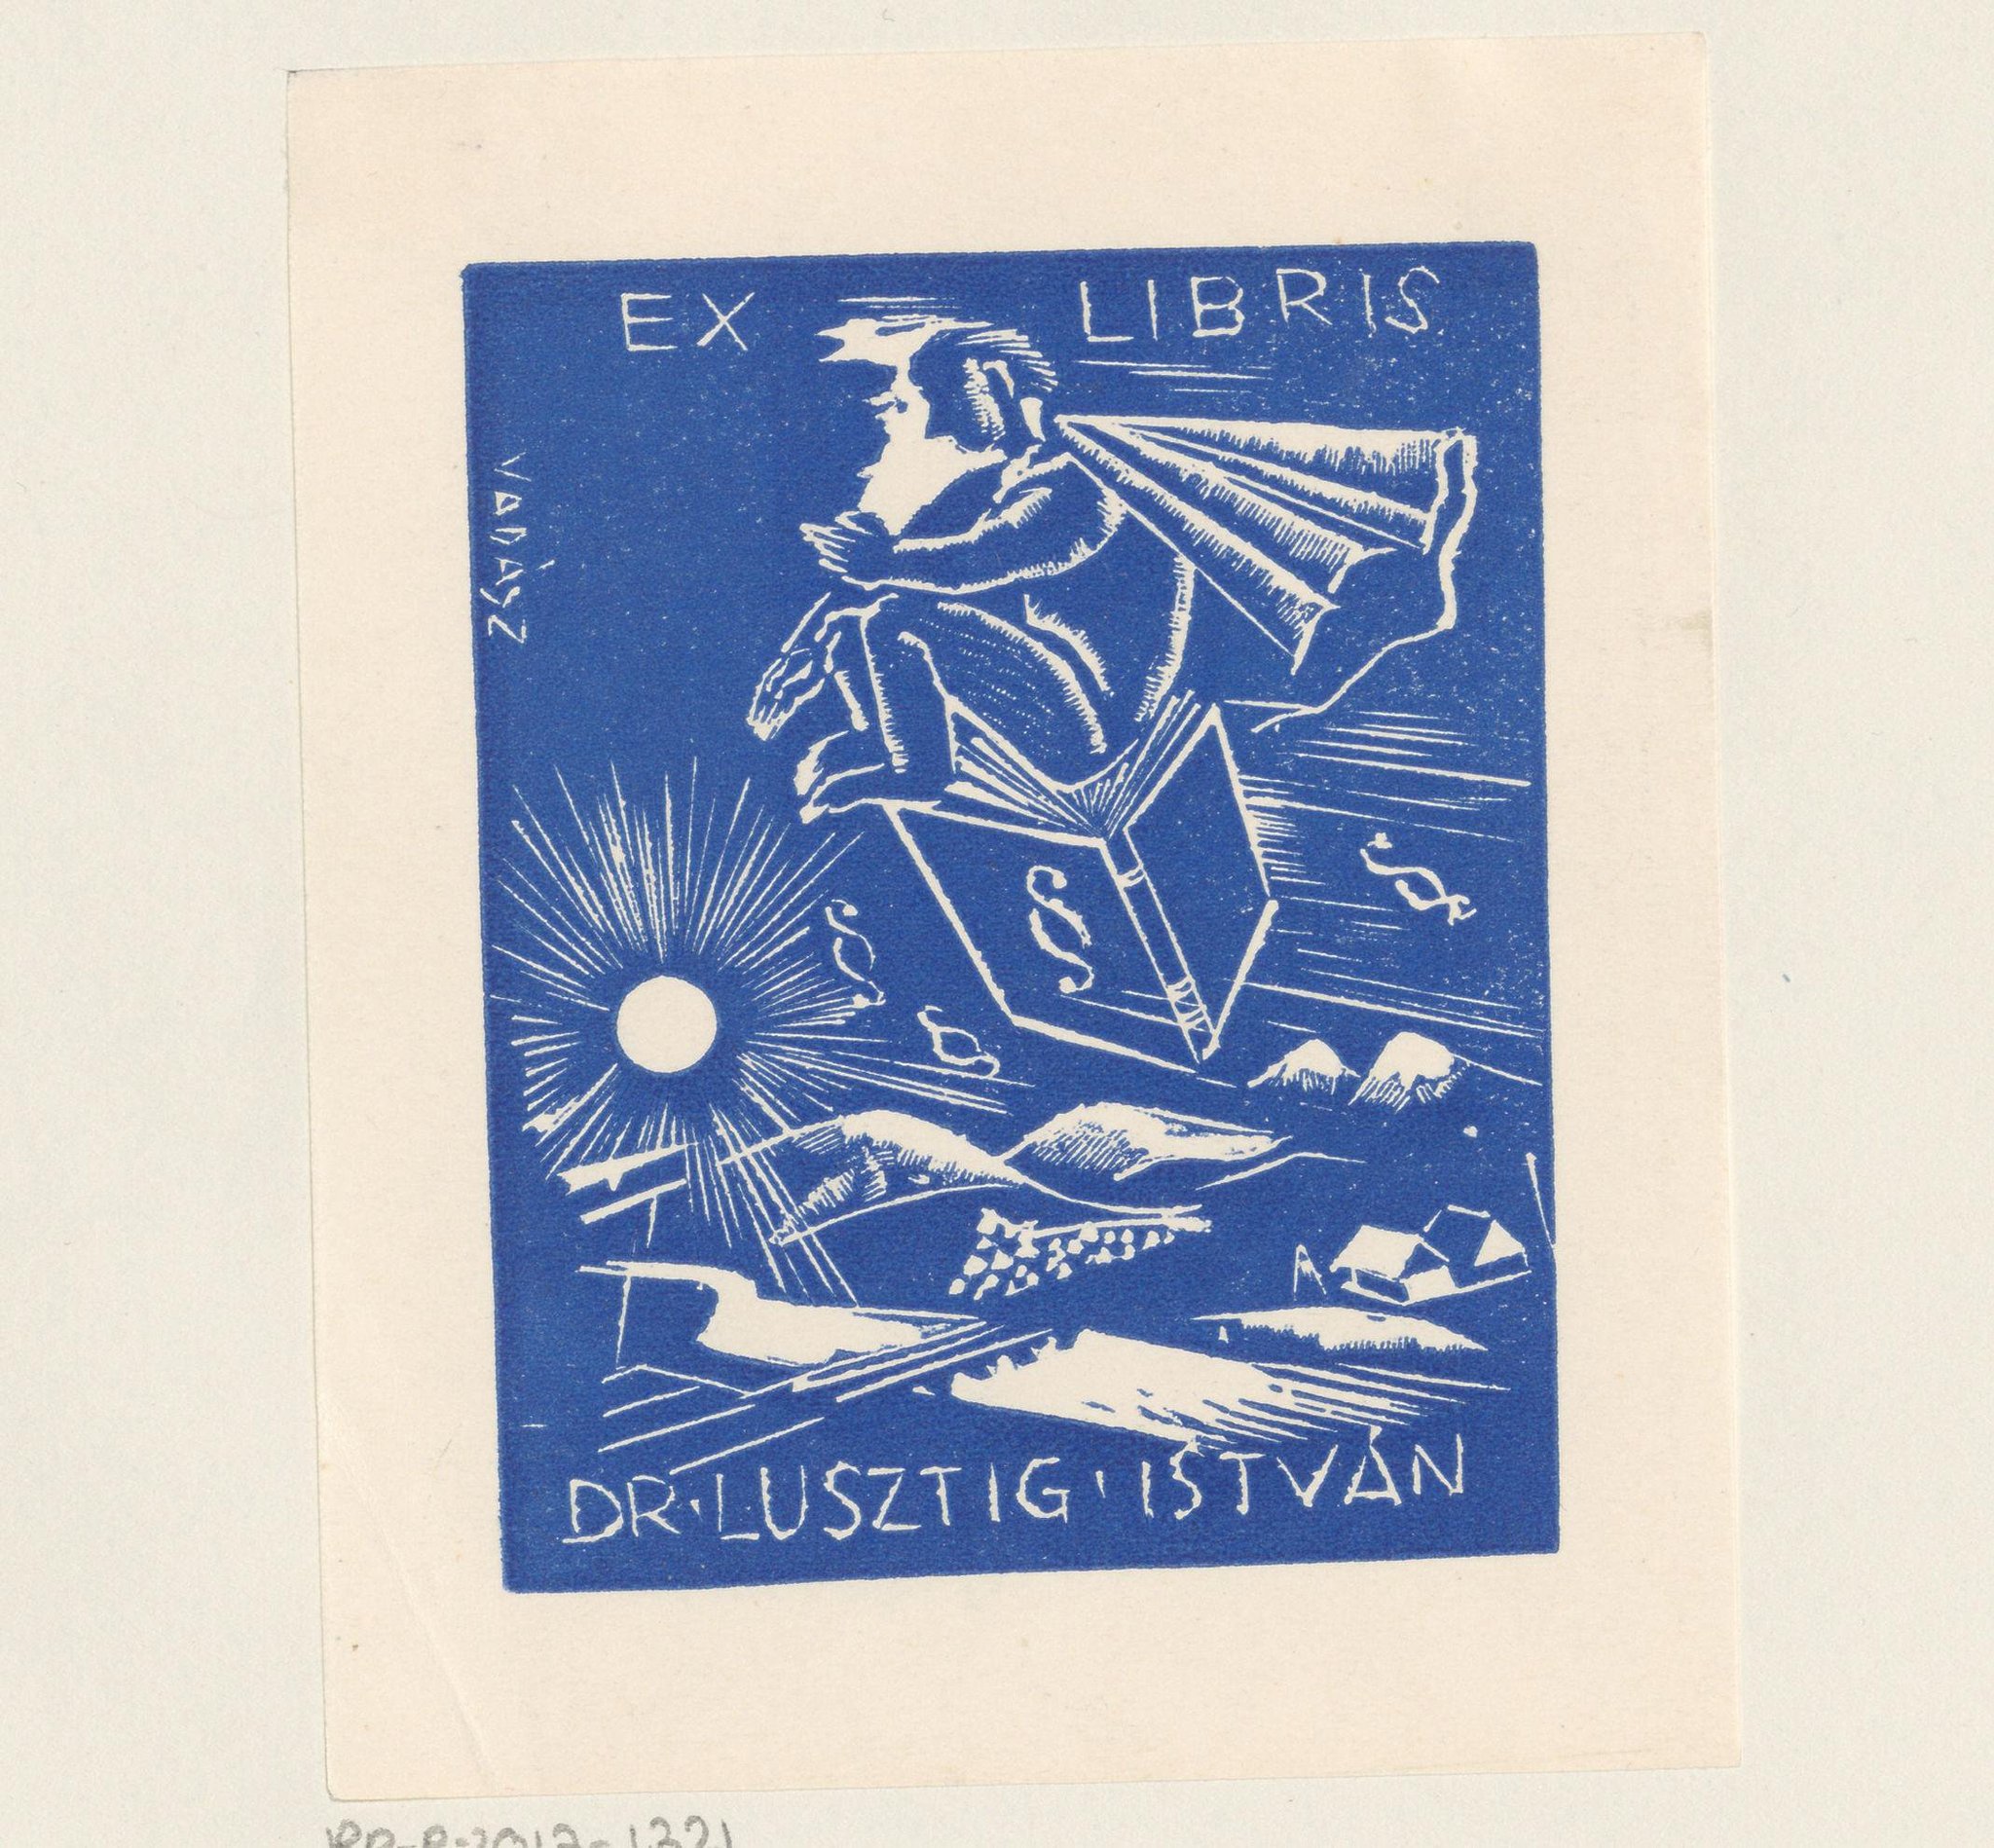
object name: bookplate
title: Ex libris van István Lusztig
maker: endre vadász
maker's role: painter, print maker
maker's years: 1901-1944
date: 1934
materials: paper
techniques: linocut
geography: debrecen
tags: low hill country, sitting figure, cape, flying, book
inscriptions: inscription: ‘Vadasz’